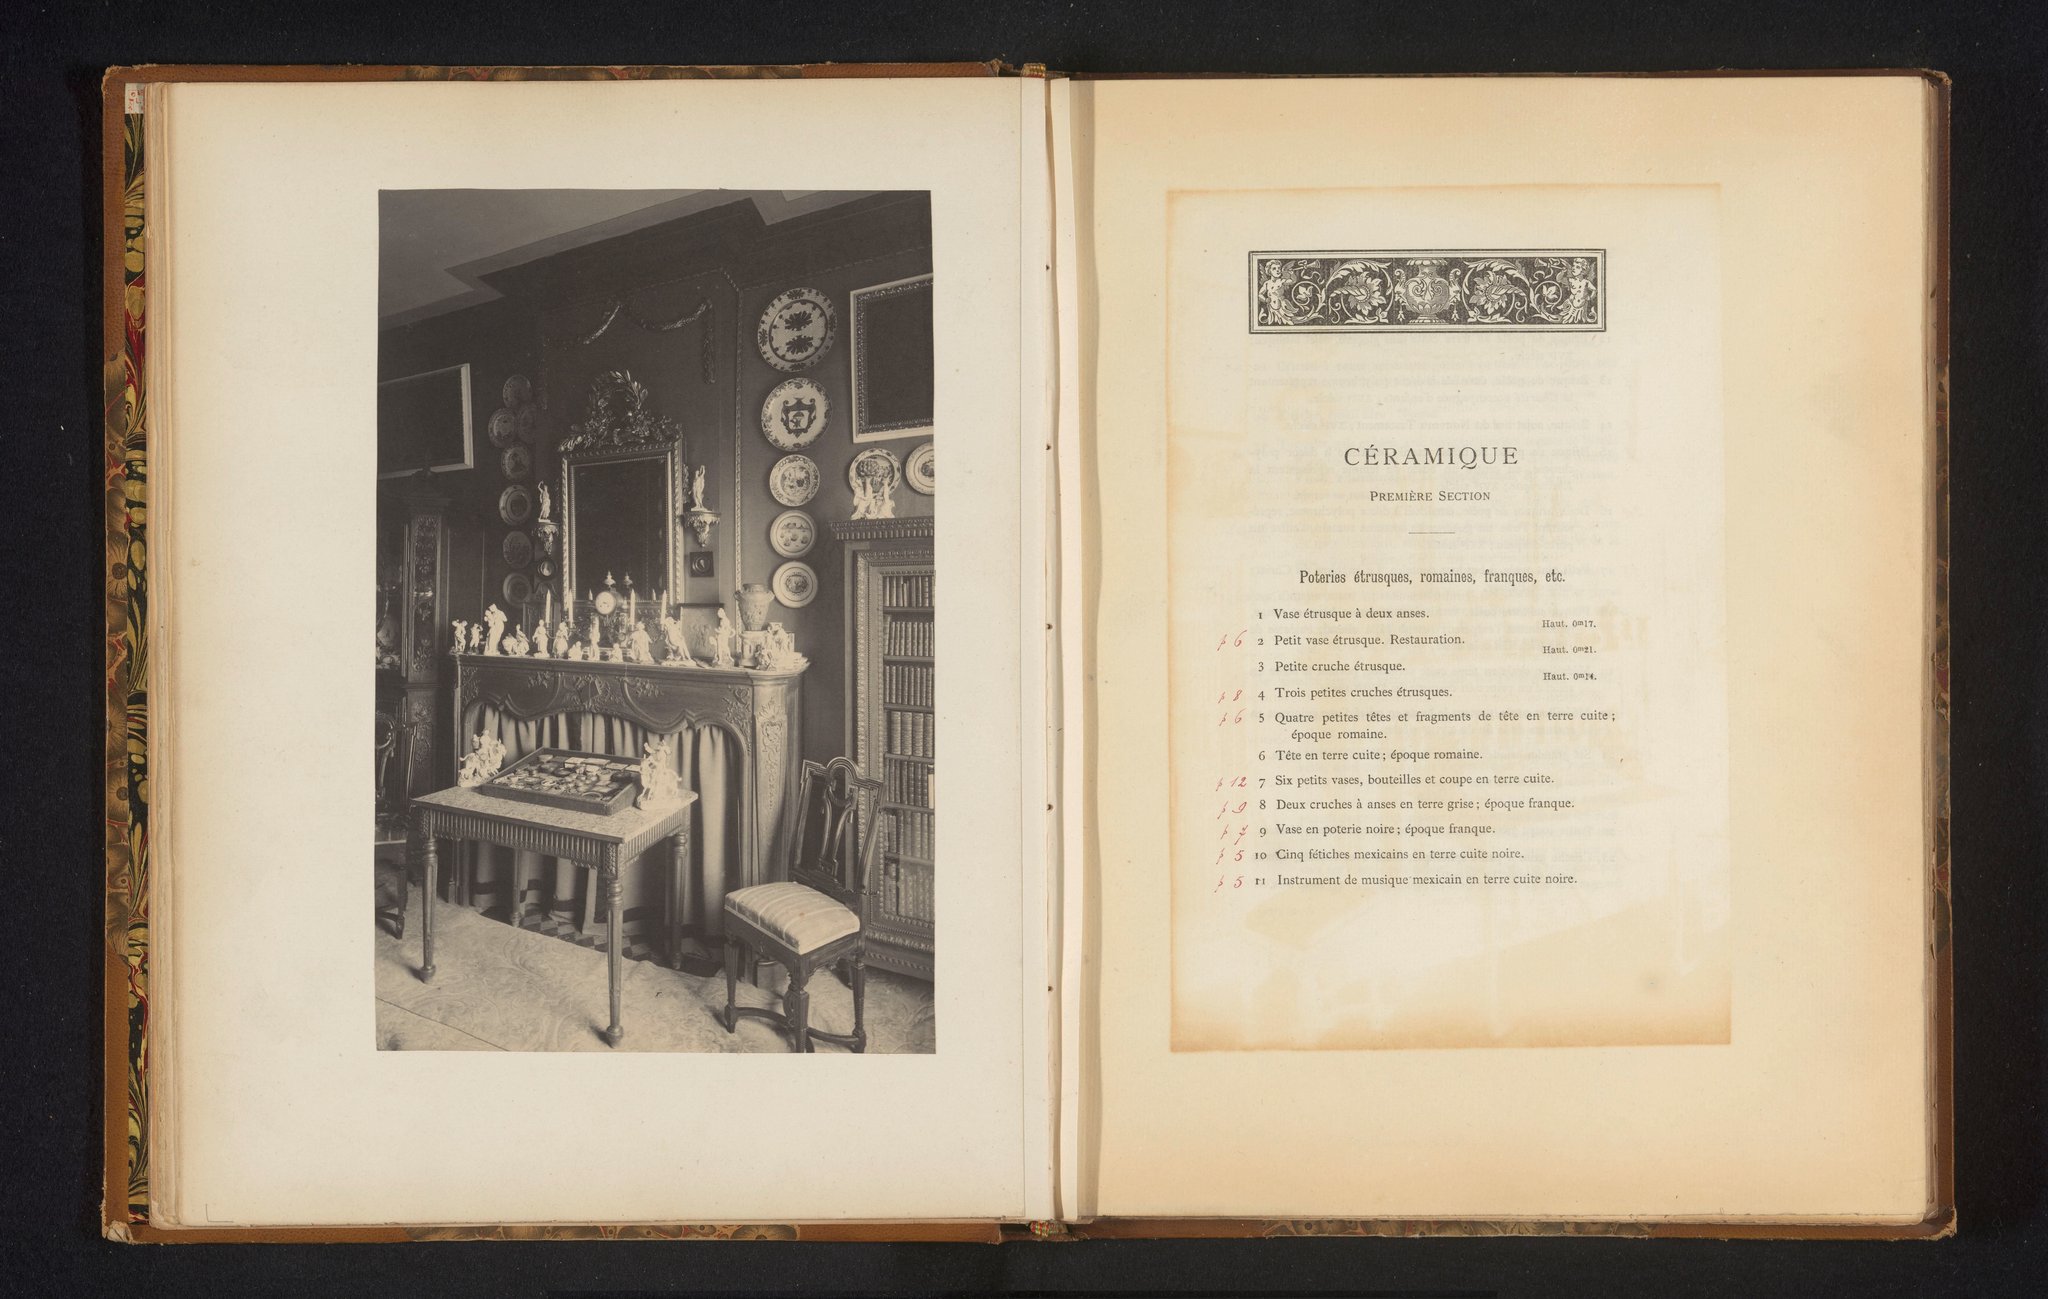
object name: page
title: Kamer in het huis van Antonin Terme met zijn collectie antiquiteiten, borden en beelden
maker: Anonymous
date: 1880-1885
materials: photographic support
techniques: platinum process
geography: liège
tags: art collection, art gallery, interior of the house, dish, plate, saucer